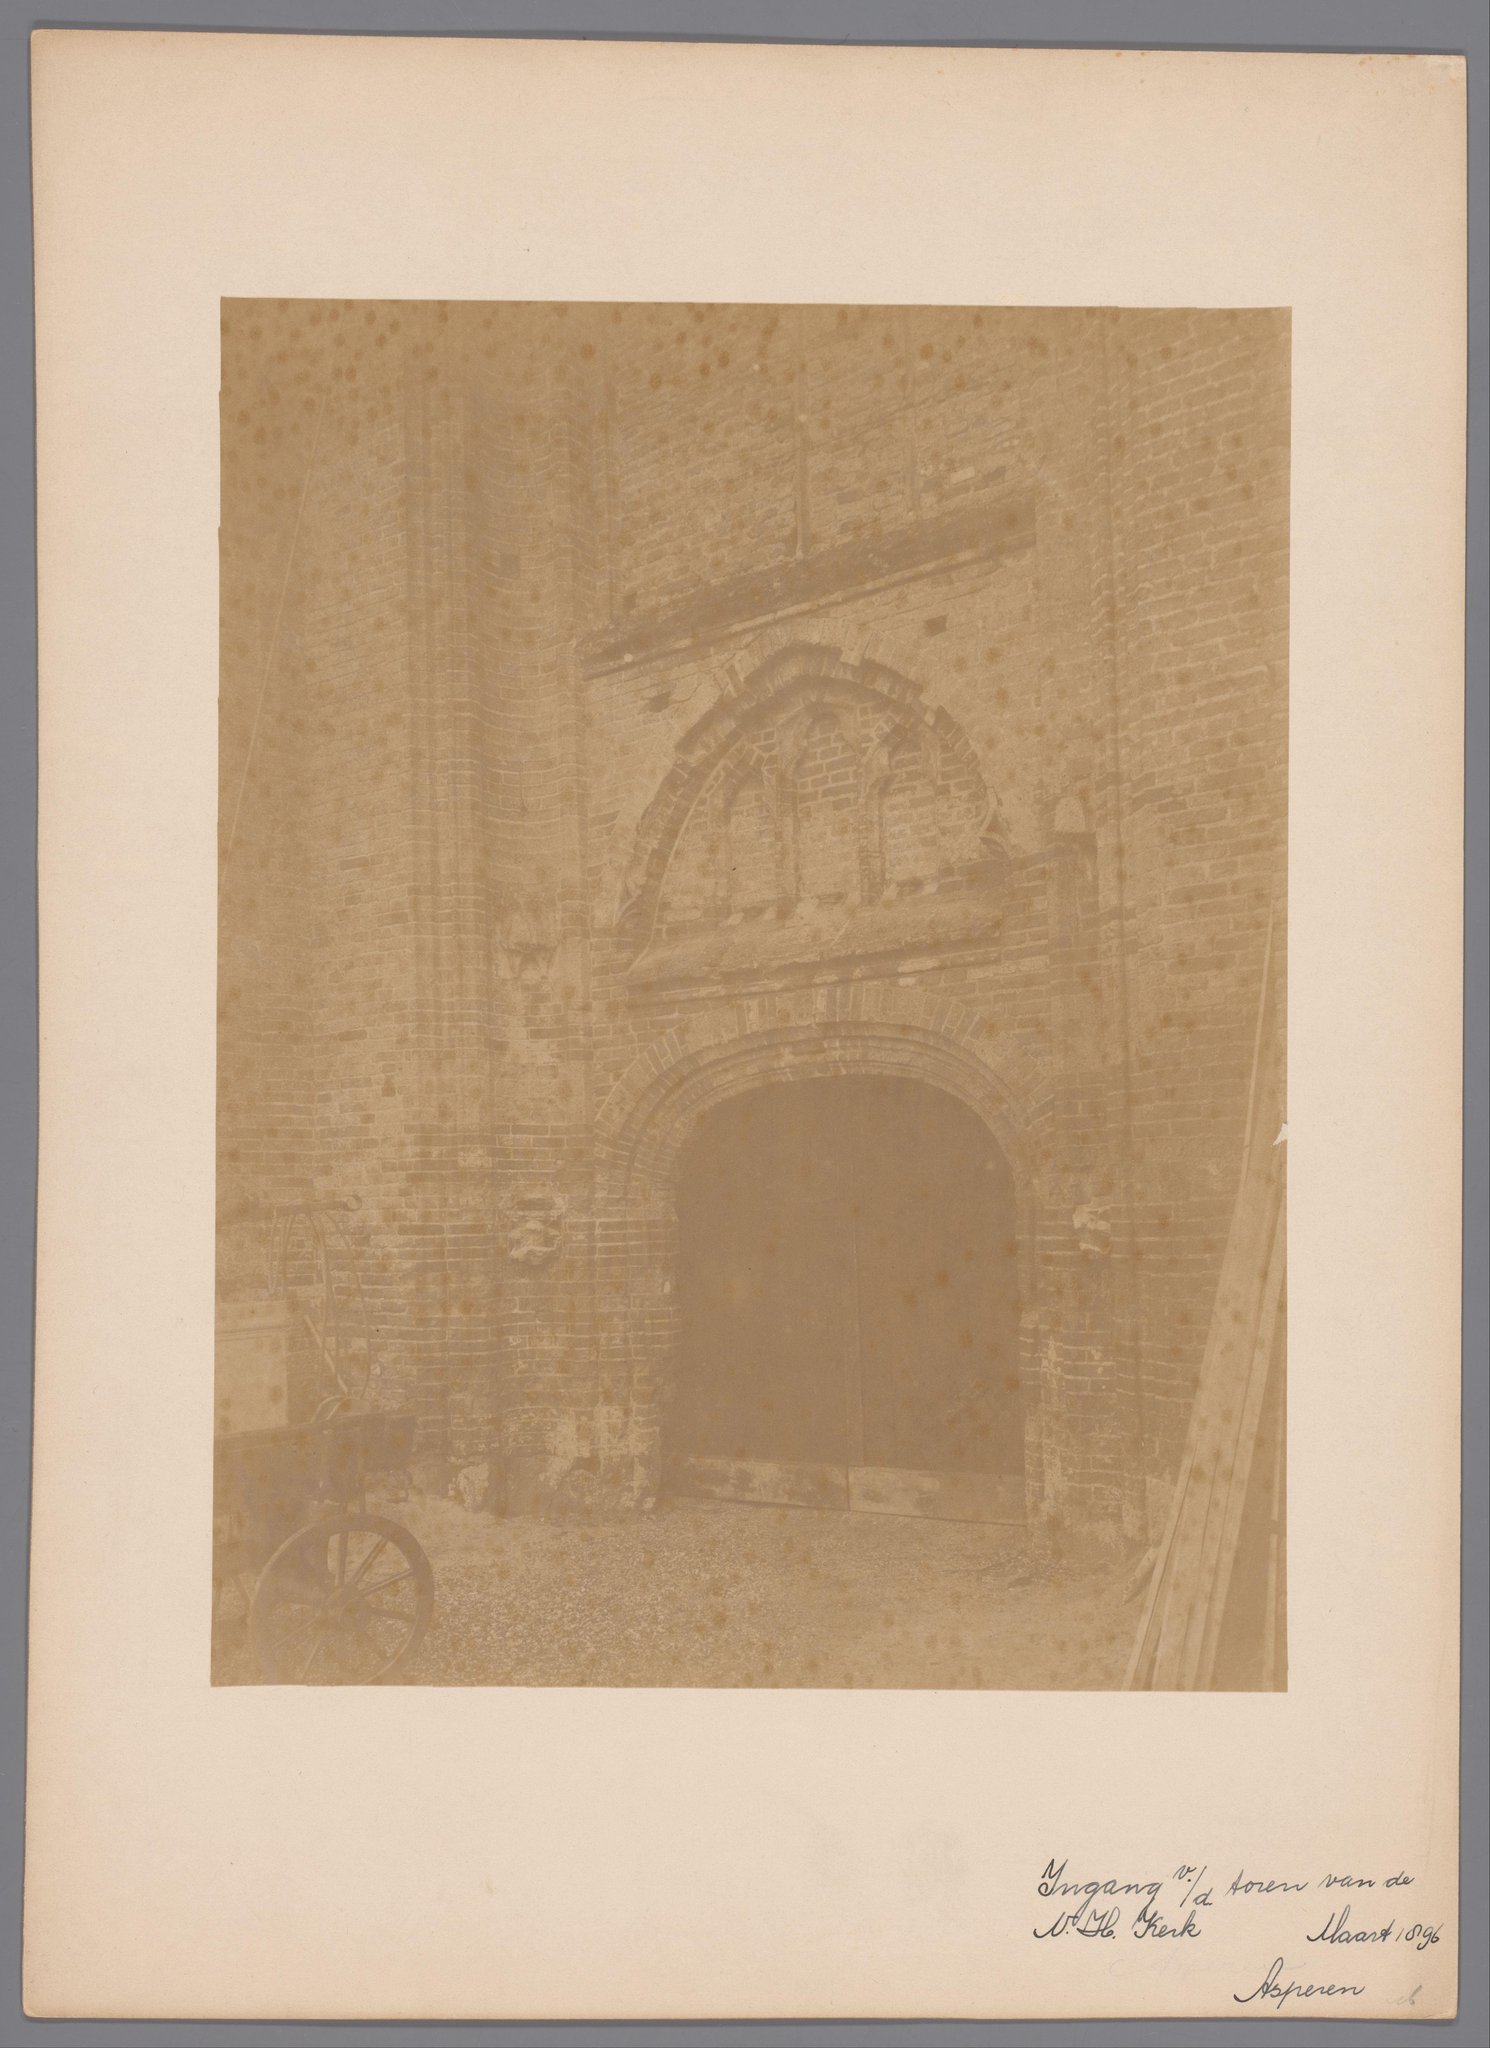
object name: photograph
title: Ingang van de toren van de Nederlands-hervormde kerk te Asperen na de brand van 1896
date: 1896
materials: cardboard, photographic support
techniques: albumen print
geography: asperen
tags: church (exterior), door, tower (of house or building)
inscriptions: annotation: ‘Asperen (Z.H.)/ Ingang v/d toren v/d N.H. Kerk/ maart 1896’, annotation: ‘Ingang v/d toren van de N.H. Kerk/ maart 1896 Asperen’